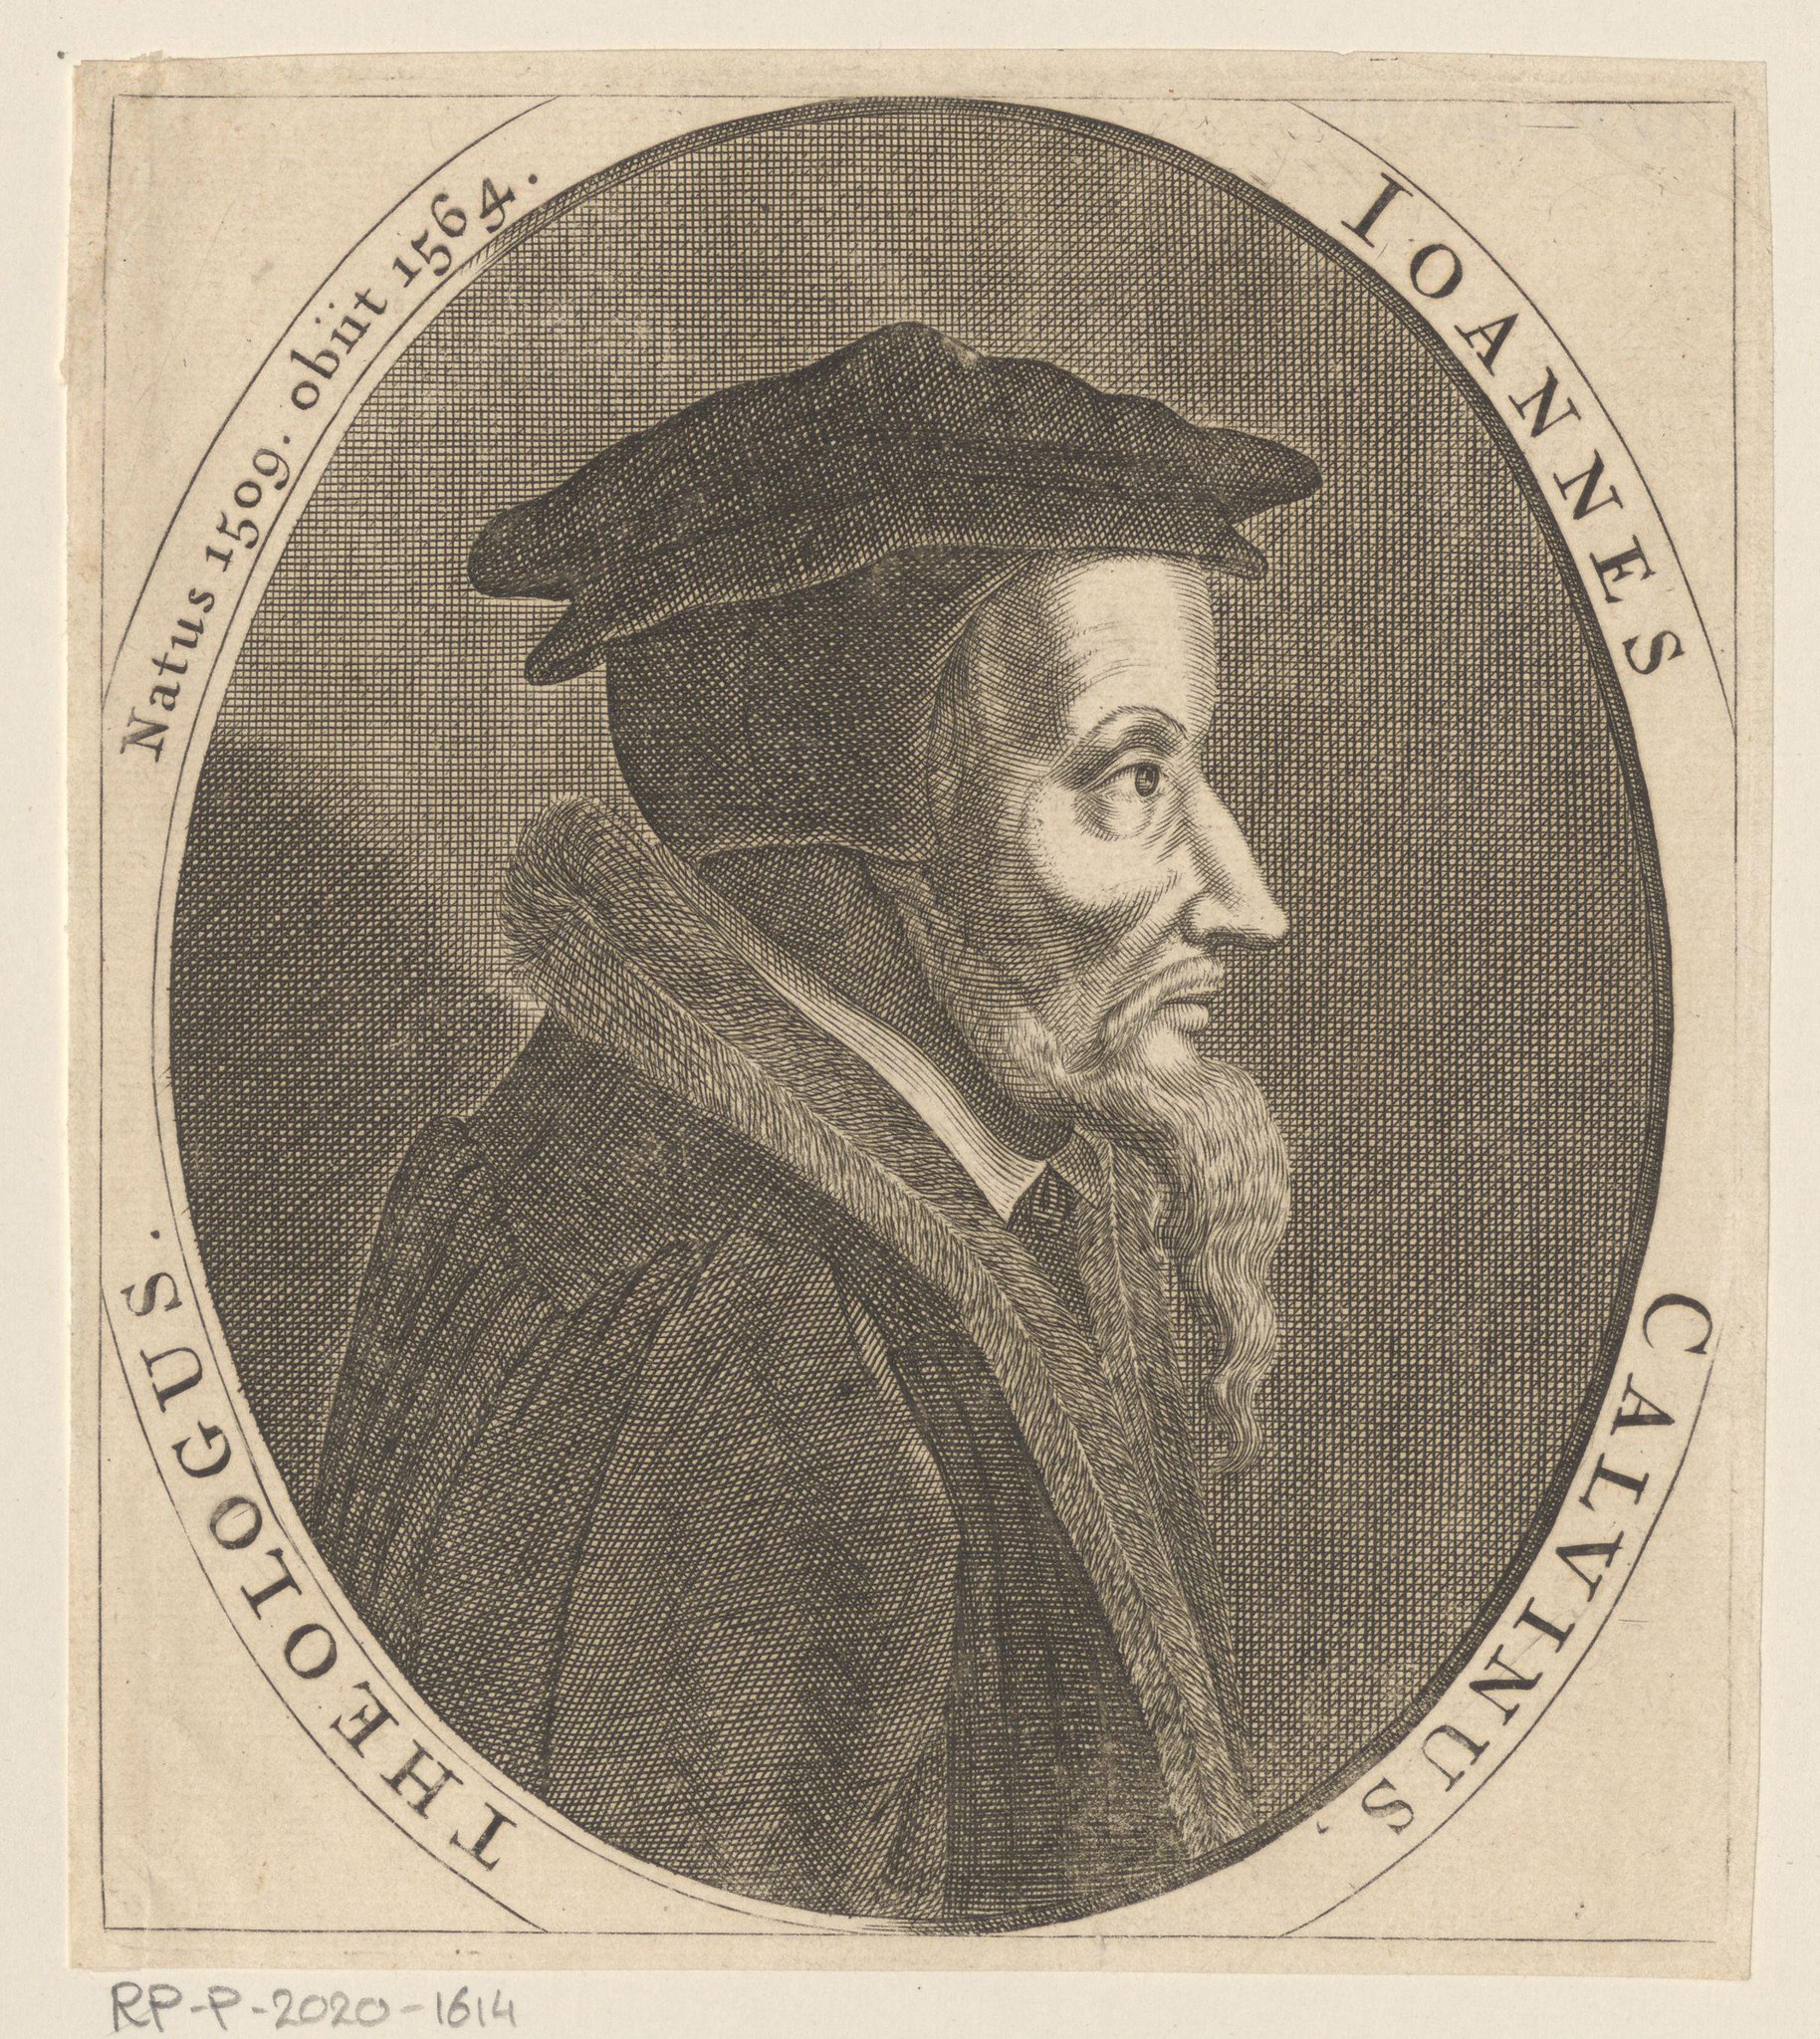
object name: print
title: Portret van Johannes Calvijn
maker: Anonymous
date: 1600-1699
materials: paper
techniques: engraving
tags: historical persons